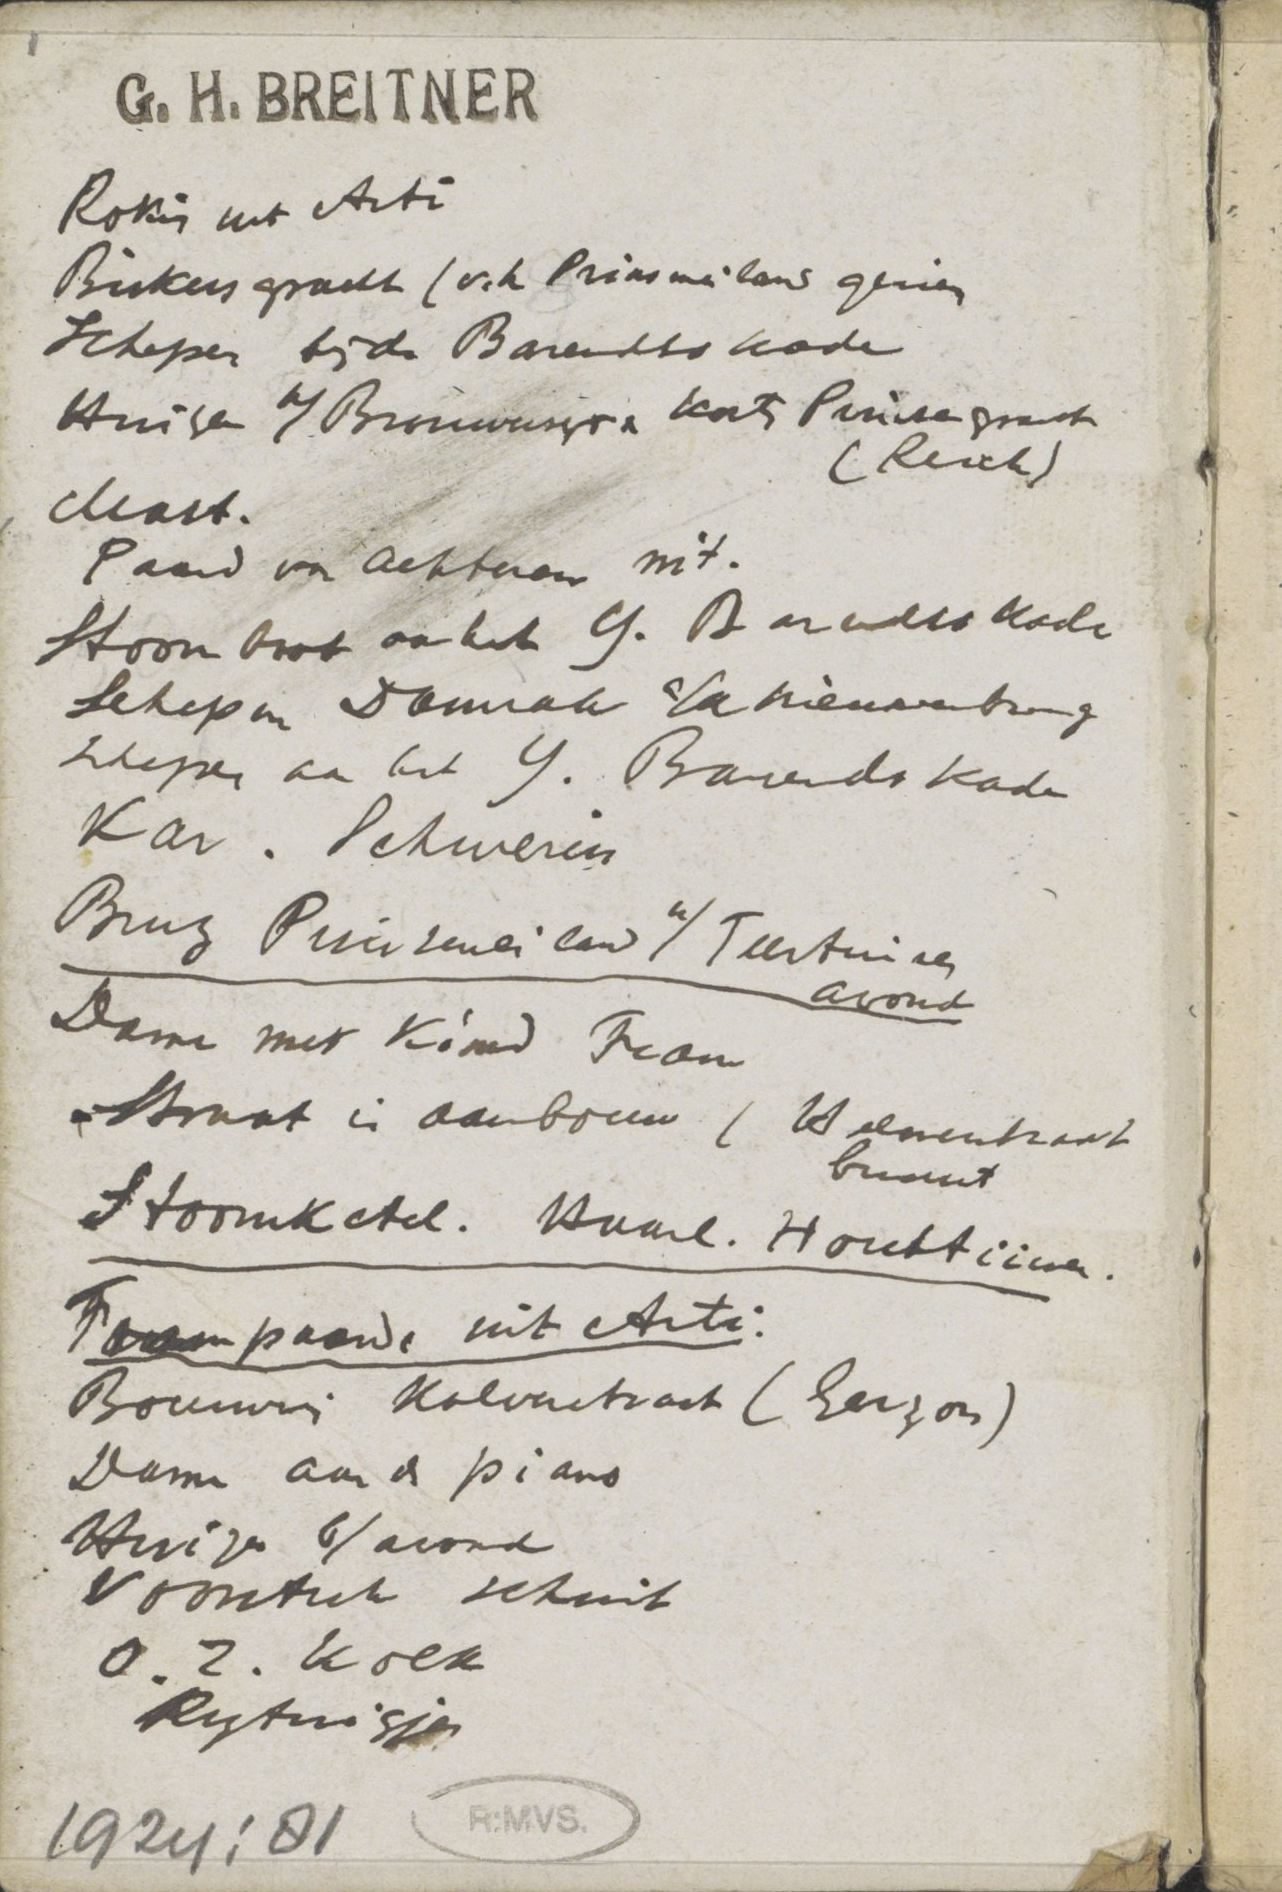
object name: sketchbook leaf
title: Annotaties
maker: george hendrik breitner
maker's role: draughtsman, painter, print maker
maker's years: 1857-1923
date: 1892-1923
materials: ink, paper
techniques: writing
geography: amsterdam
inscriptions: collector's mark: Lugt 2228, workshop stamp: ‘G.H. Breitner’, annotation: ‘Rokin uit Arti/ Bickersgracht (v.h. Prinseneiland gezien/ Schepen bij de Barendtskade/ Huizen a/ Brouwersgra Kort Prinsengracht/ (Reich)/ Mast./ Paard van achteren wit./ Stoomboot aan het IJ. Barendtskade/ Schepen Damrak a/d Nieuwebrug/ Schepen aan het IJ. Barendskade/ Kar. Schwerin/ Brug Prinseneiland a/ Teertuinen/ avond/ Dame met kind Tram/ Straat in aanbouw/ (Helmerstraat/ buurt[?]/ Stoomketel. Haarl. Houttuinen./ Trampaarde uit Arti./ Bouwrij Kalverstraat ([...])/ Dame aan de piano/ Huizen b/ avond/ Voorstuk schuit/ O.Z. Kolk/ Rijtuigjes’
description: Aantekeningen. Pagina 1 uit een schetsboek met 45 bladen vervaardigd te Schwerin en Amsterdam.